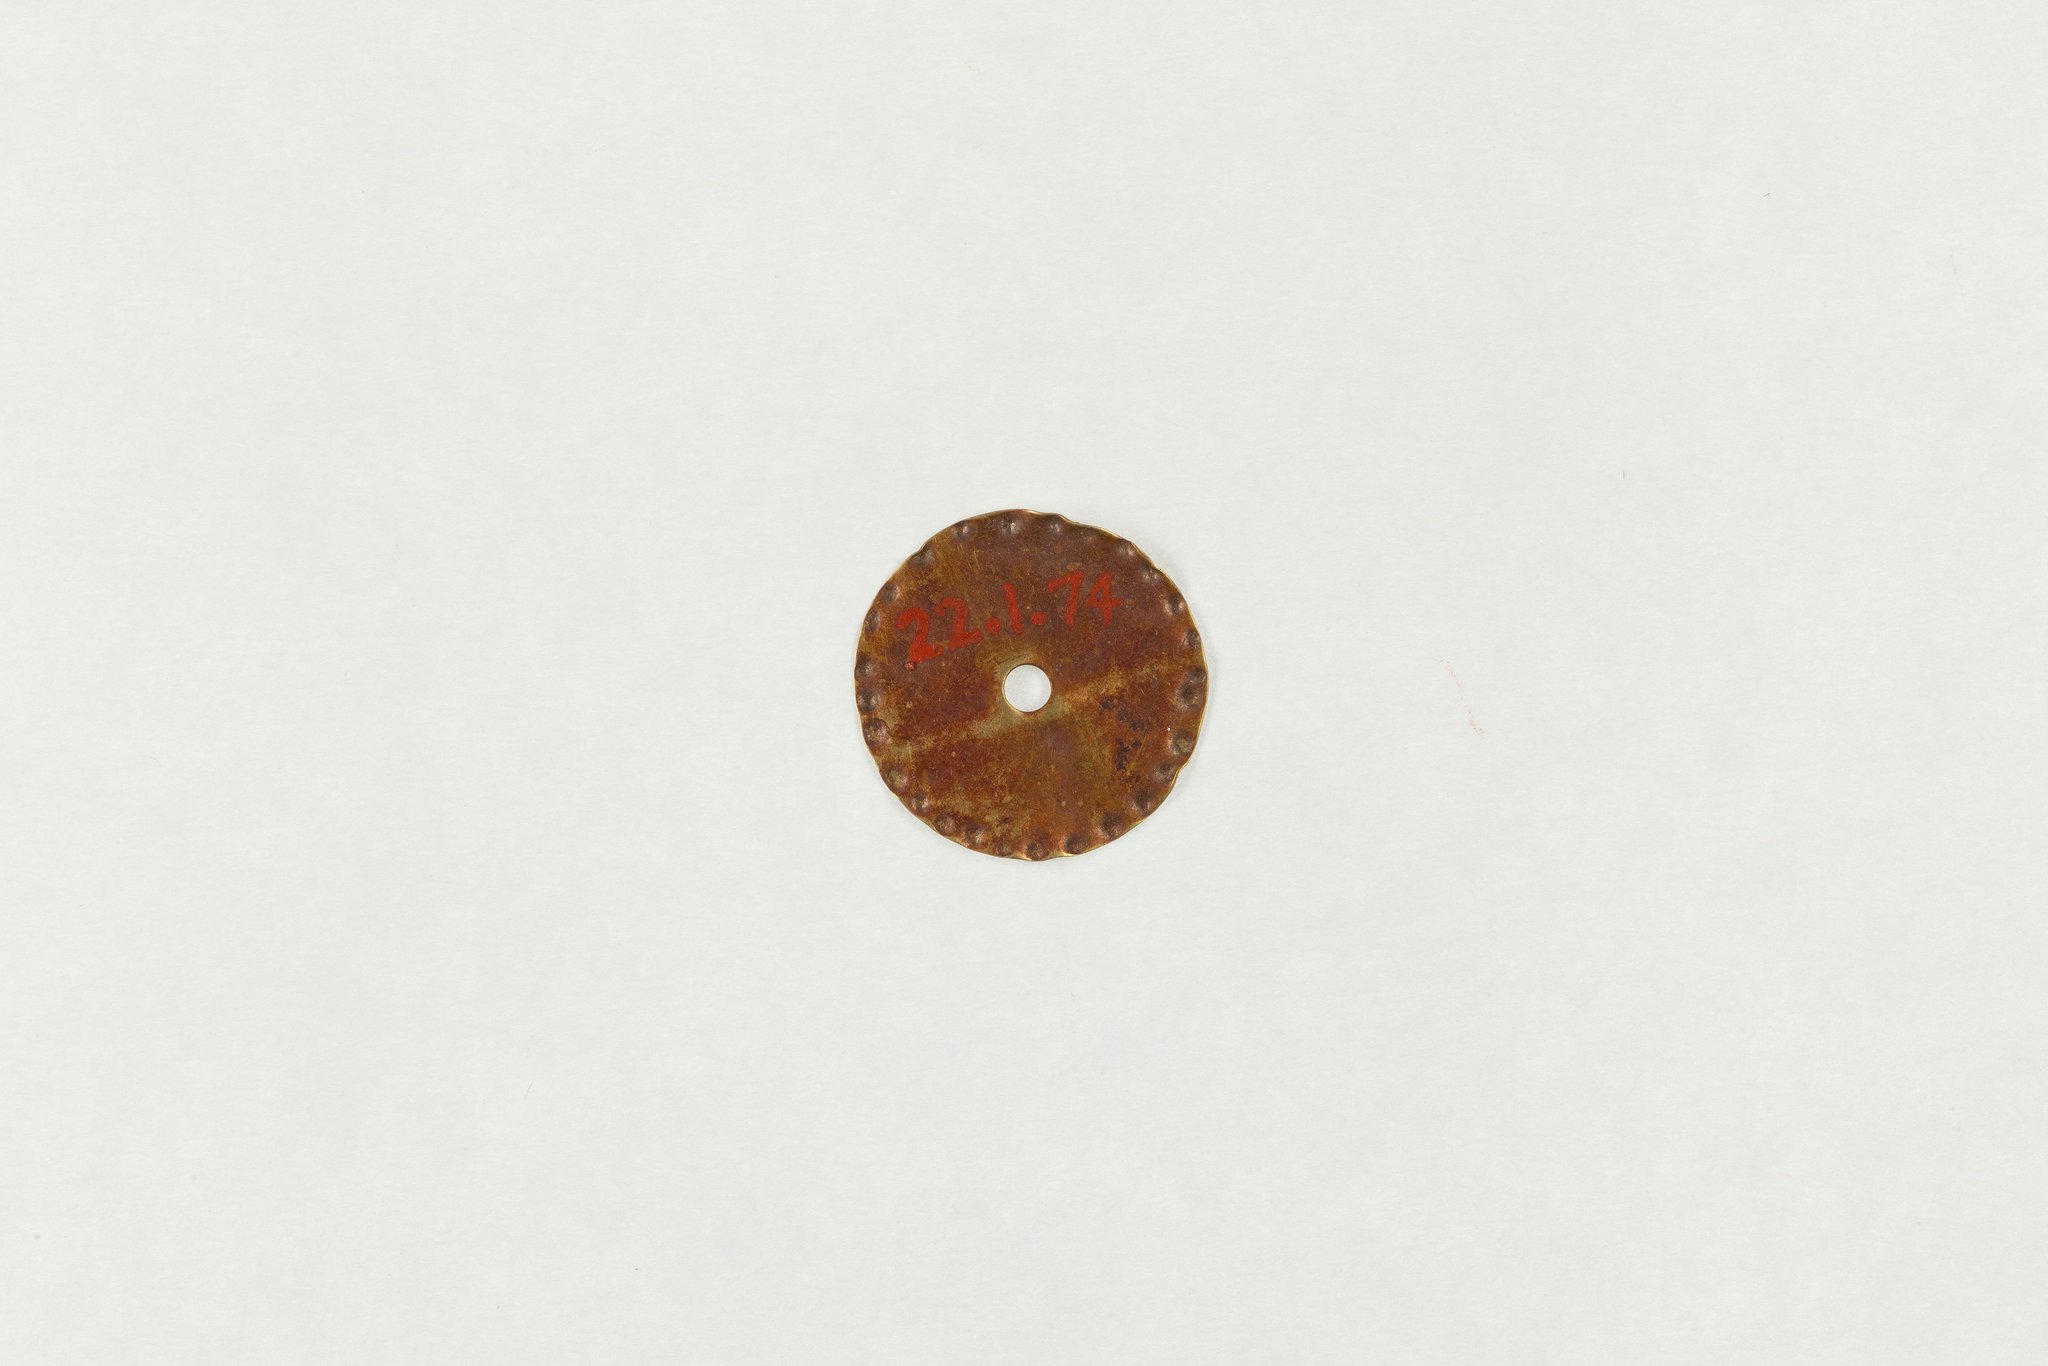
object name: disk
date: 1981-1803 BCE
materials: gold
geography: egypt